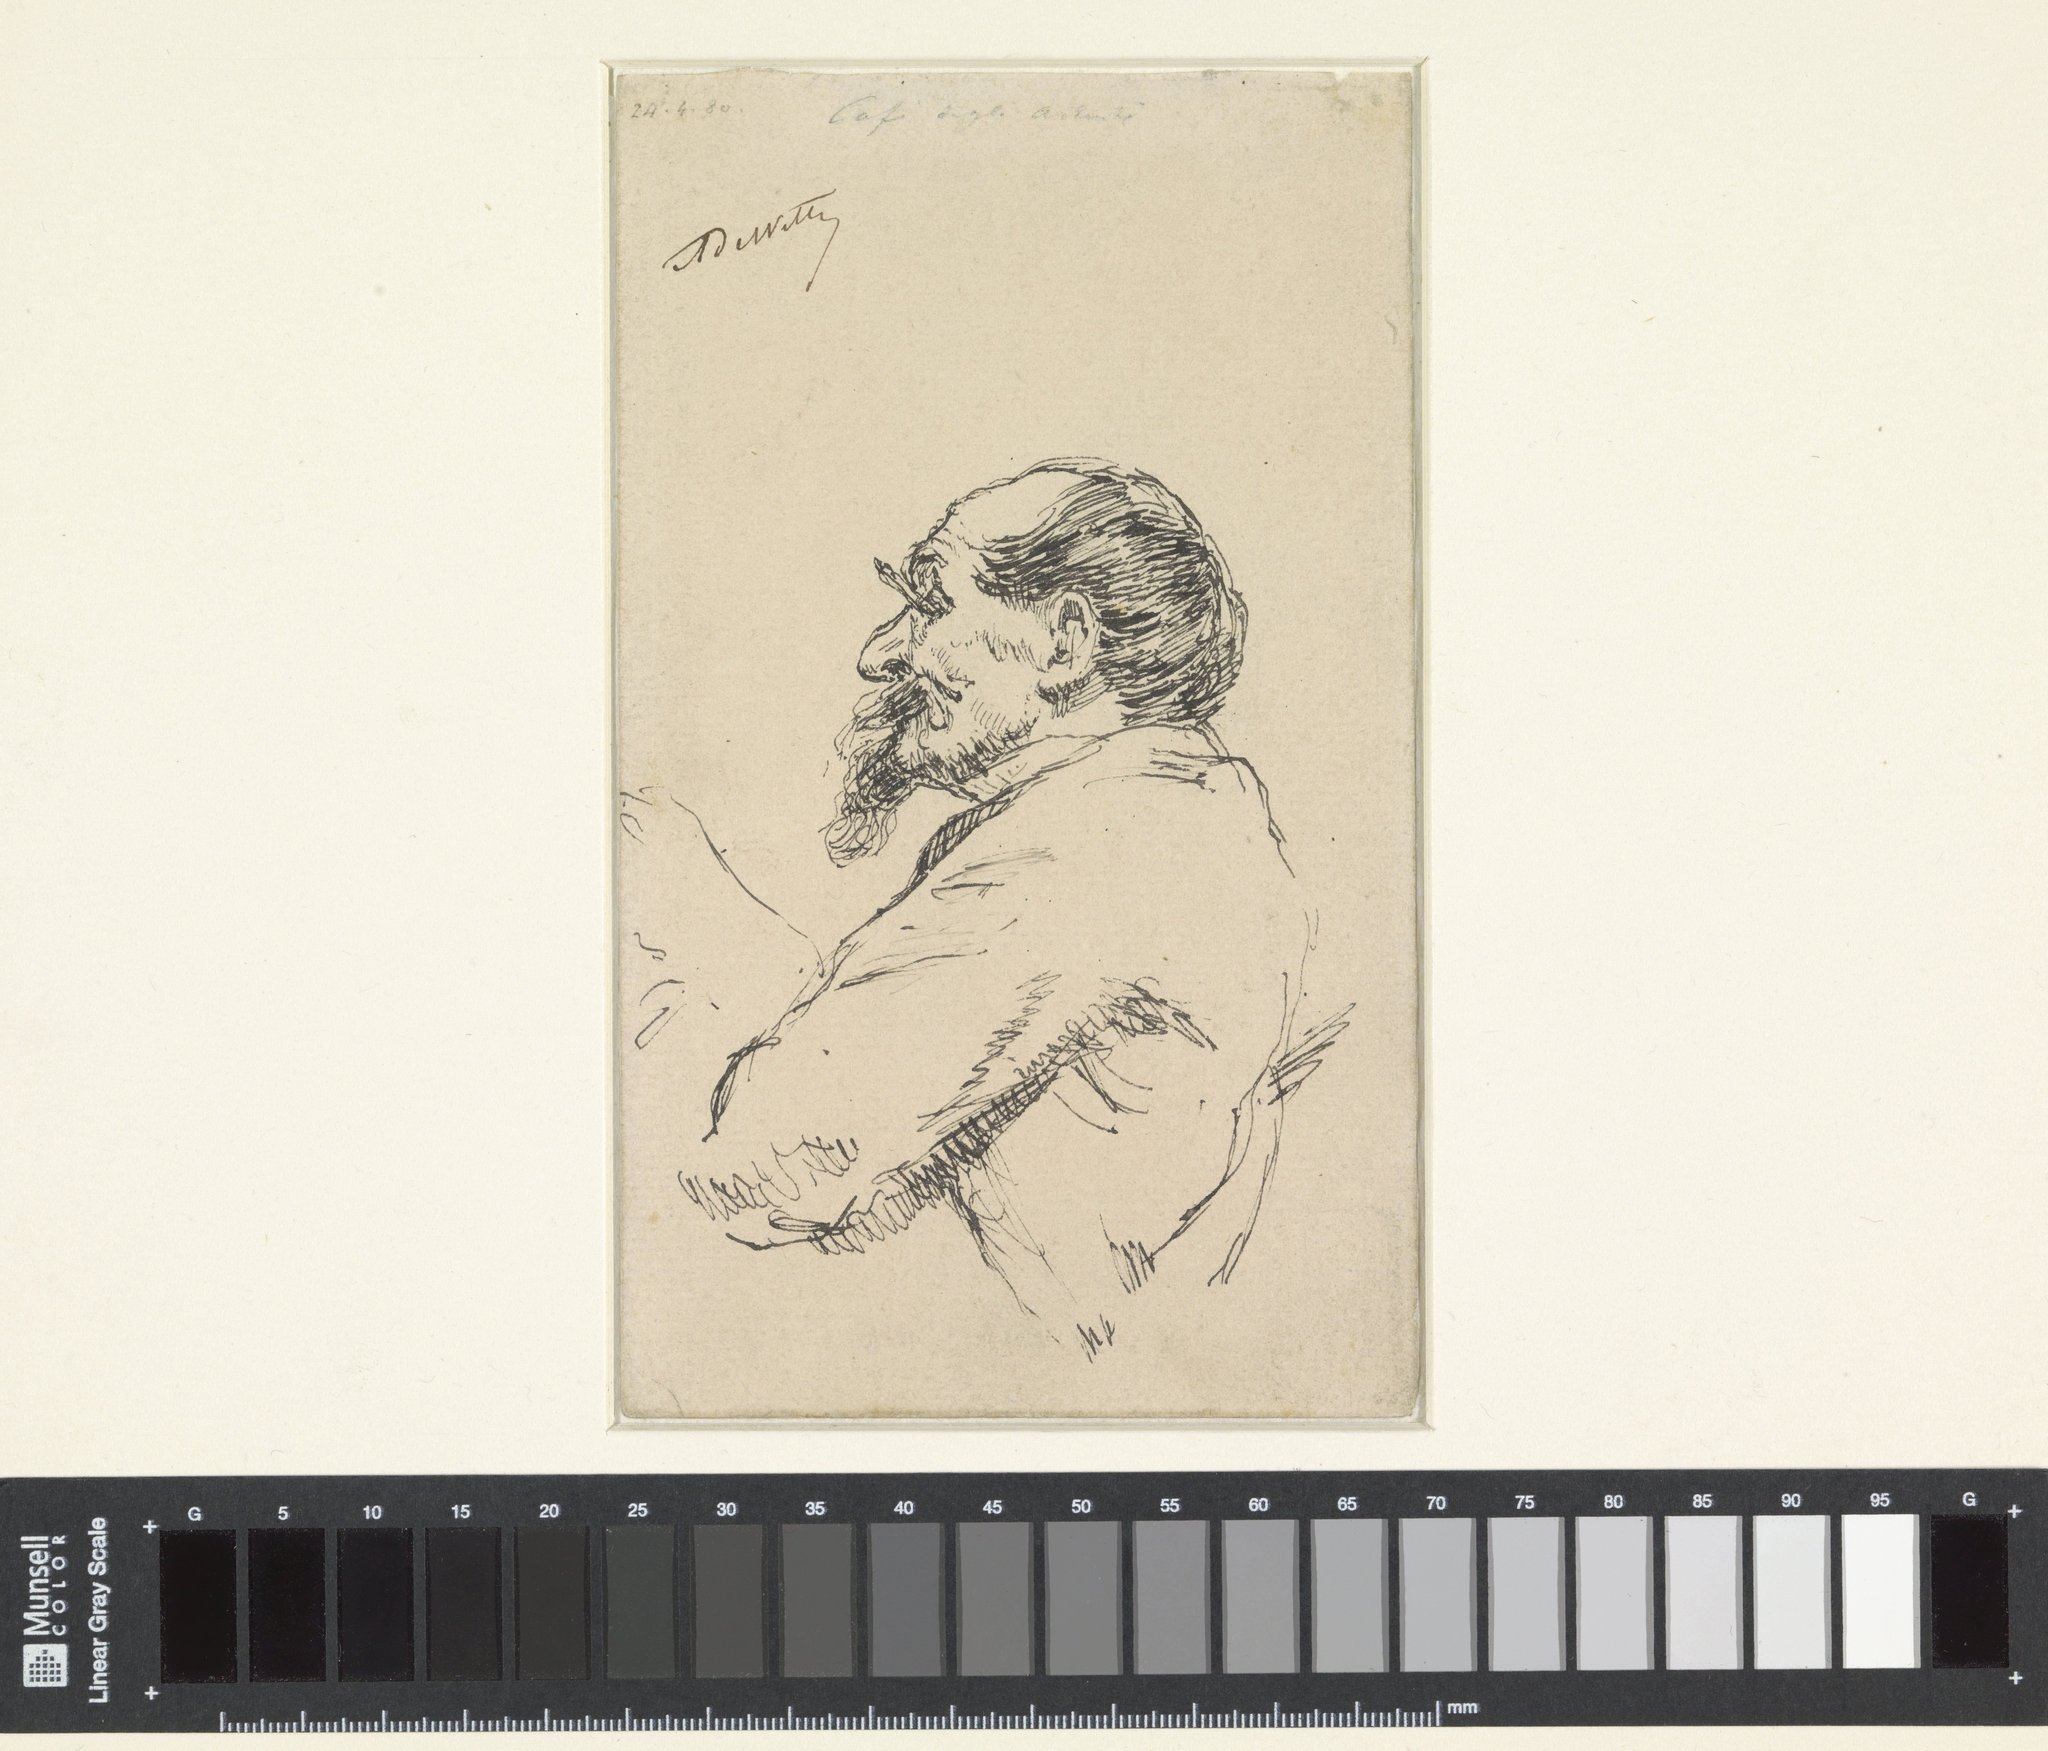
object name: drawing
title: Krantlezende heer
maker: giuseppe de nittis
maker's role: draughtsman, painter, print maker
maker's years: 1846-1884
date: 1880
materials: ink, paper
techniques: pen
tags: reading, newspaper, news-sheet, male sex; man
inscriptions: date and inscription: ‘Café degli artisti, 24:4:'80’